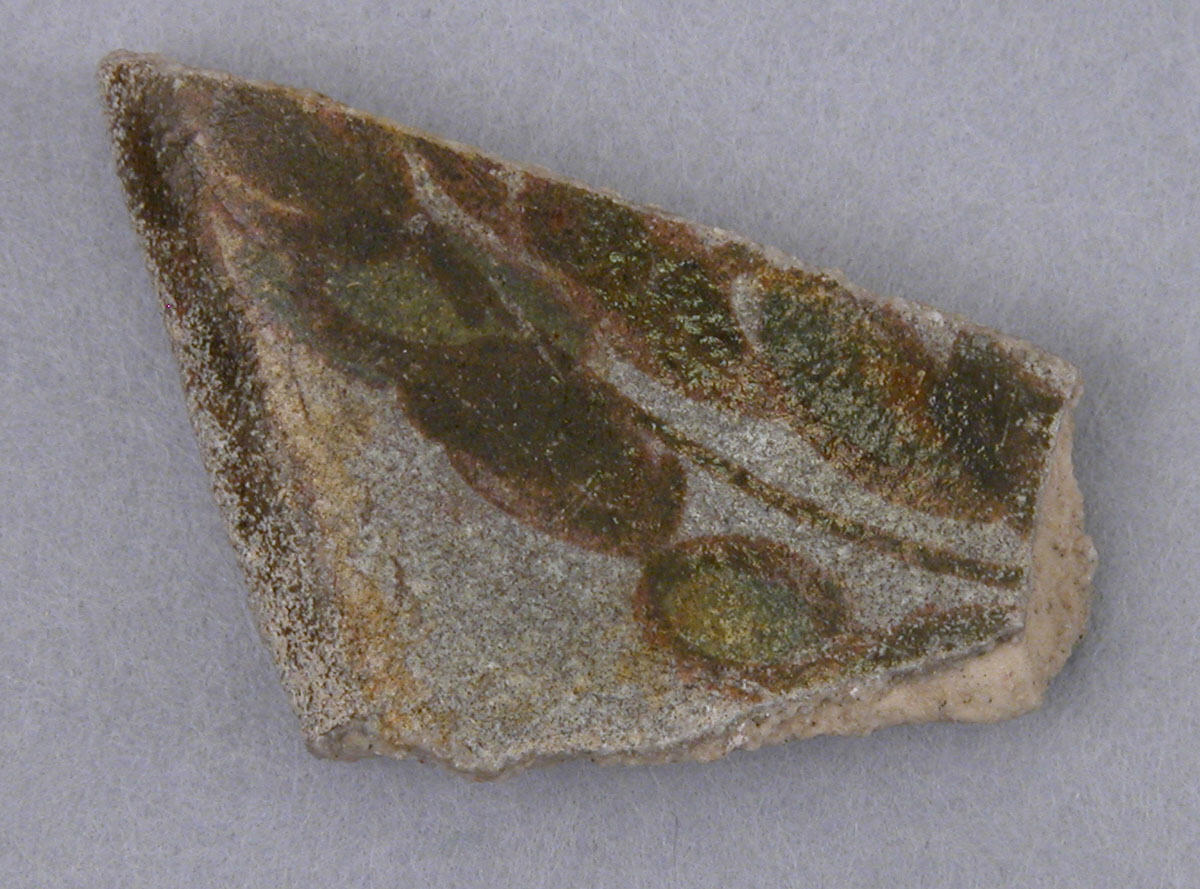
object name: fragment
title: Ceramic Fragment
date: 801-900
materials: earthenware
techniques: glazing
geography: saudi arabia